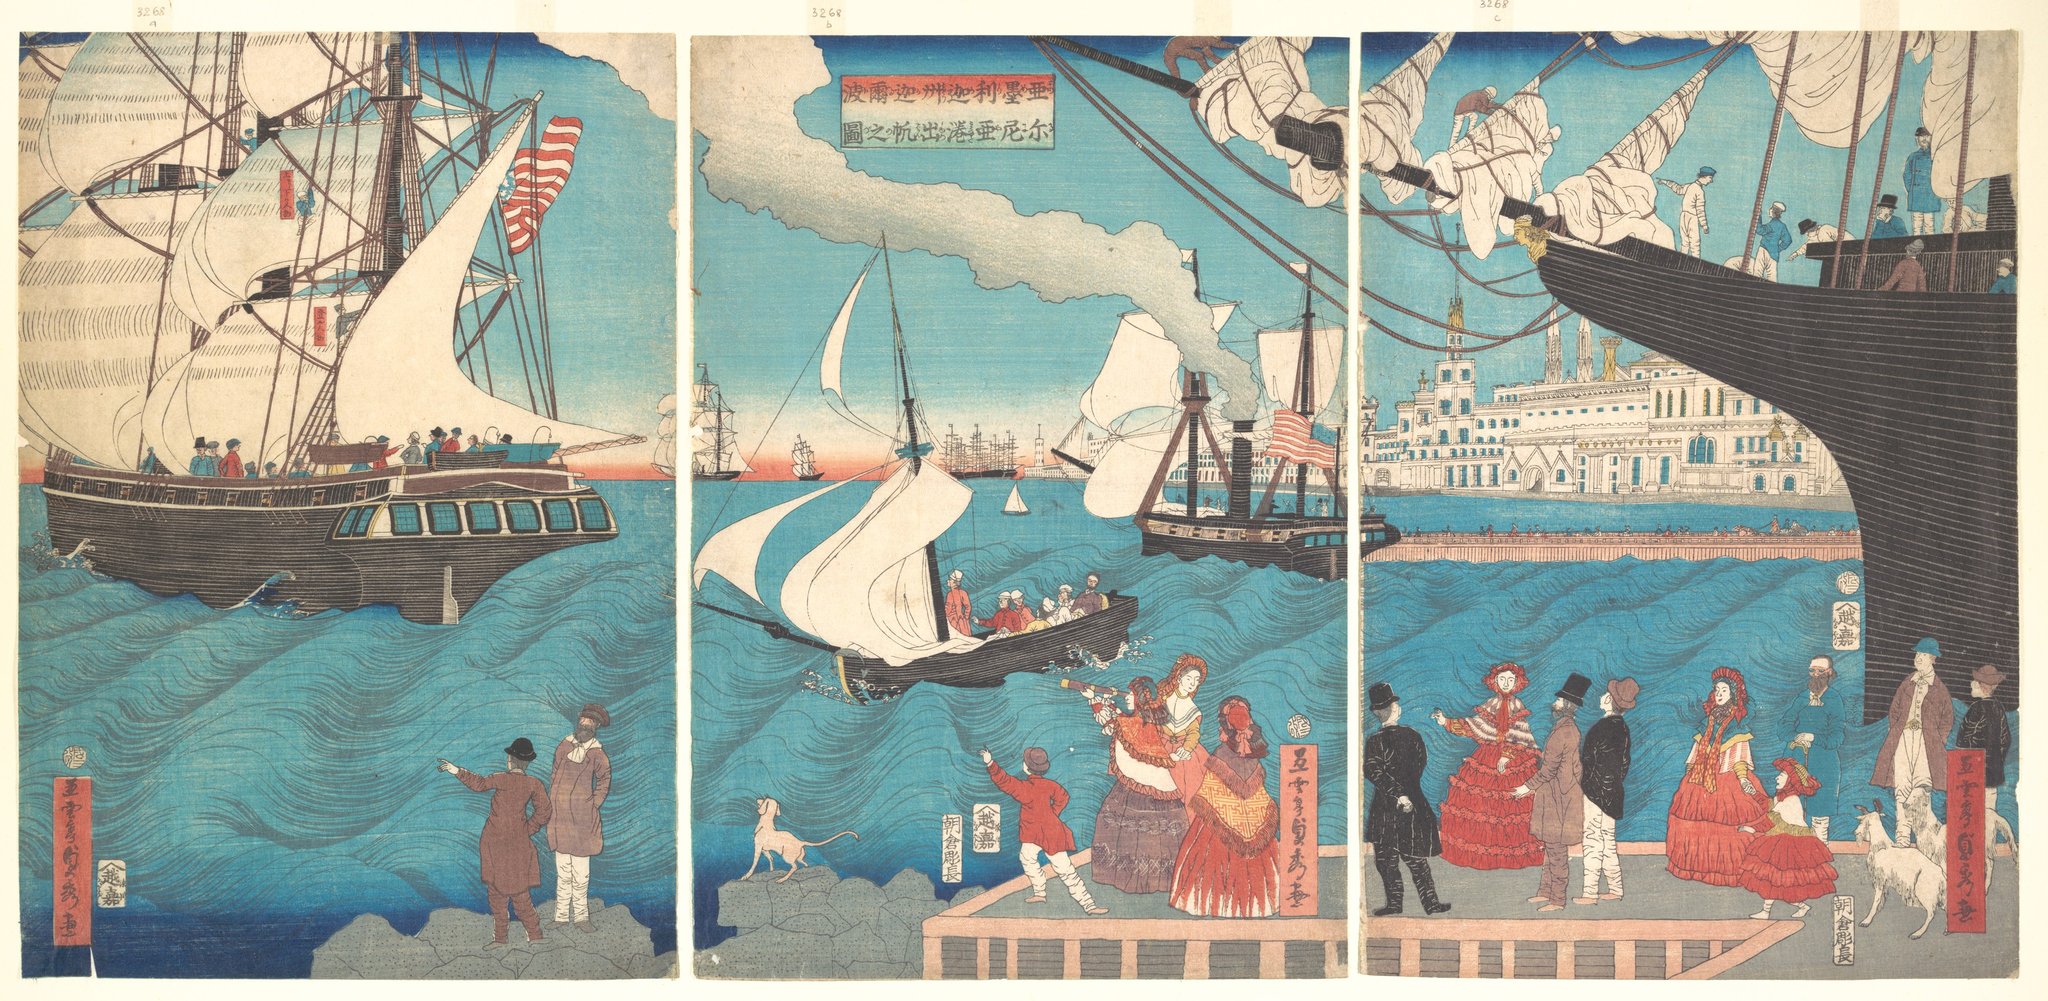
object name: print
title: Sailing from a California Port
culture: japanese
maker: utagawa (gountei) sadahide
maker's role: artist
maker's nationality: japanese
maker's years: 1807-1873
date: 1862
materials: ink, paper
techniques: woodblock print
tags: men,women,ships